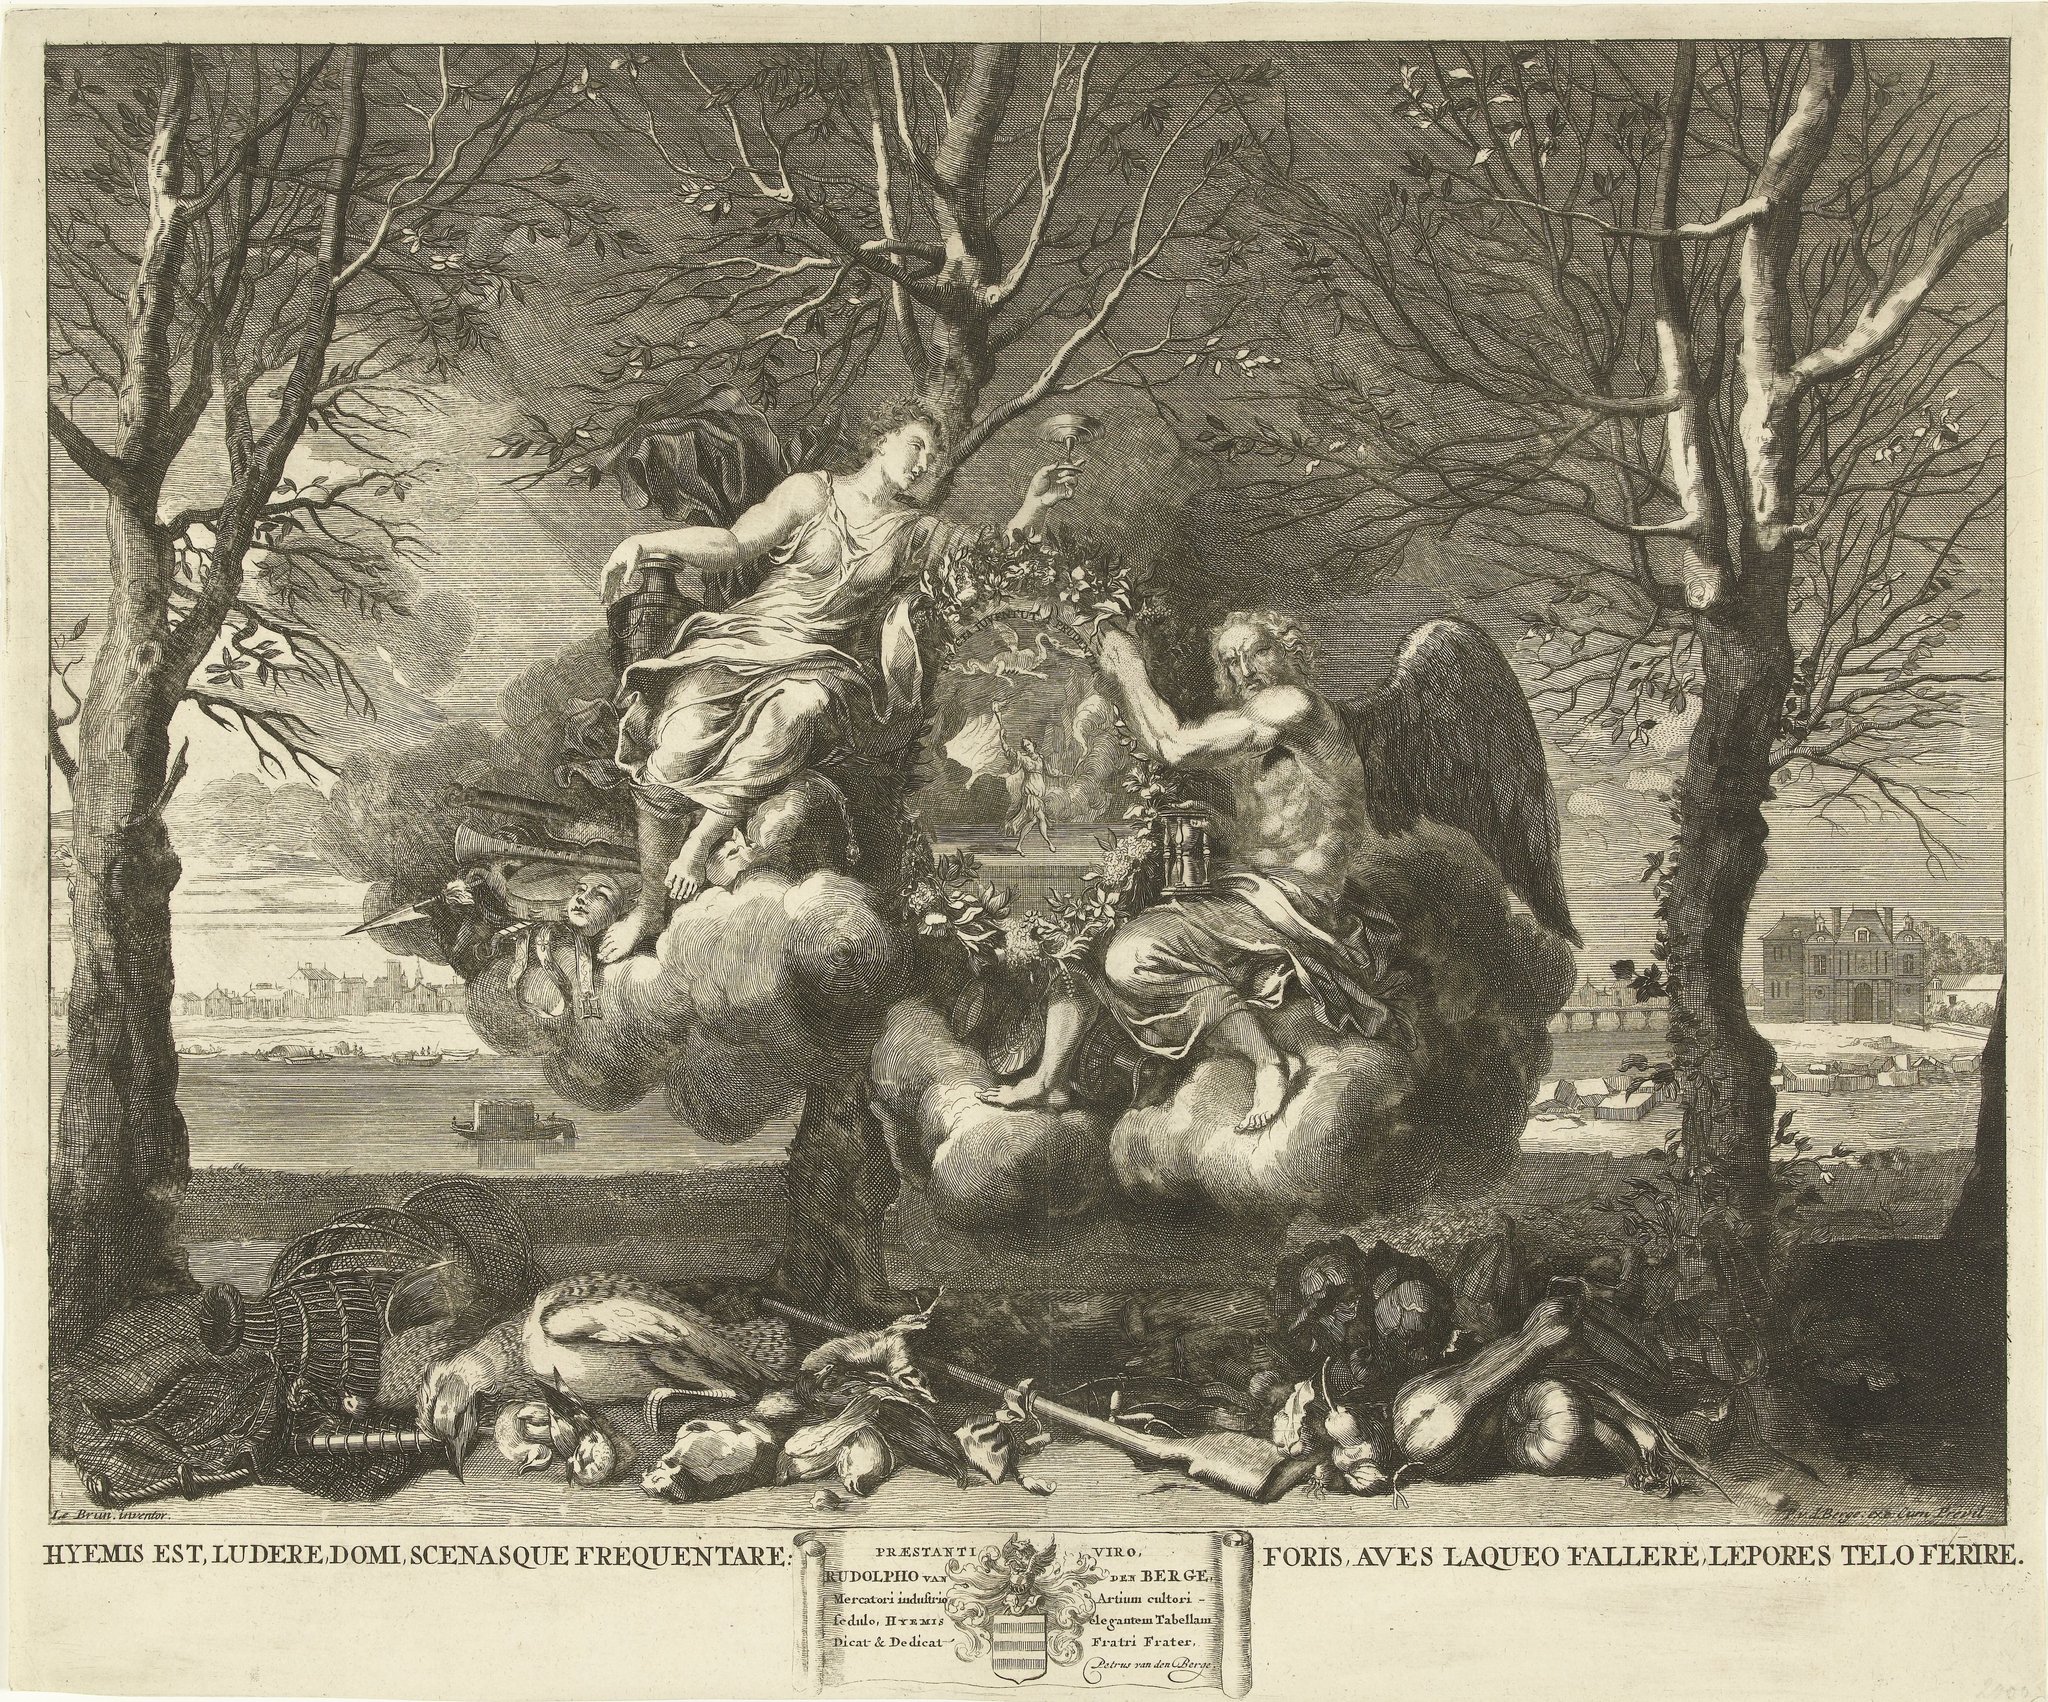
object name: print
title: Hyemis est, ludere, domi scenasque frequentare (...)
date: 1694-1737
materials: paper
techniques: engraving, etching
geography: amsterdam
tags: winter half-year ~ landscapes (year divided into two seasons), young versus old age; young and old, father time, man with wings and scythe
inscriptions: collector's mark: Lugt 2228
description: Vader Tijd zit op een wolk, naast zich een schild met een voorstelling van een jonge vrouw die met twee fakkels speelt. Hij wordt vergezeld door een personificatie van de kunsten. De vrouw leunt op een vaas en heft het glas op Vader Tijd. Op de achtergrond een karig winterlandschap. Onder de wolk liggen op de grond visnetten, dode vogels, een geweer en verschillende groente.